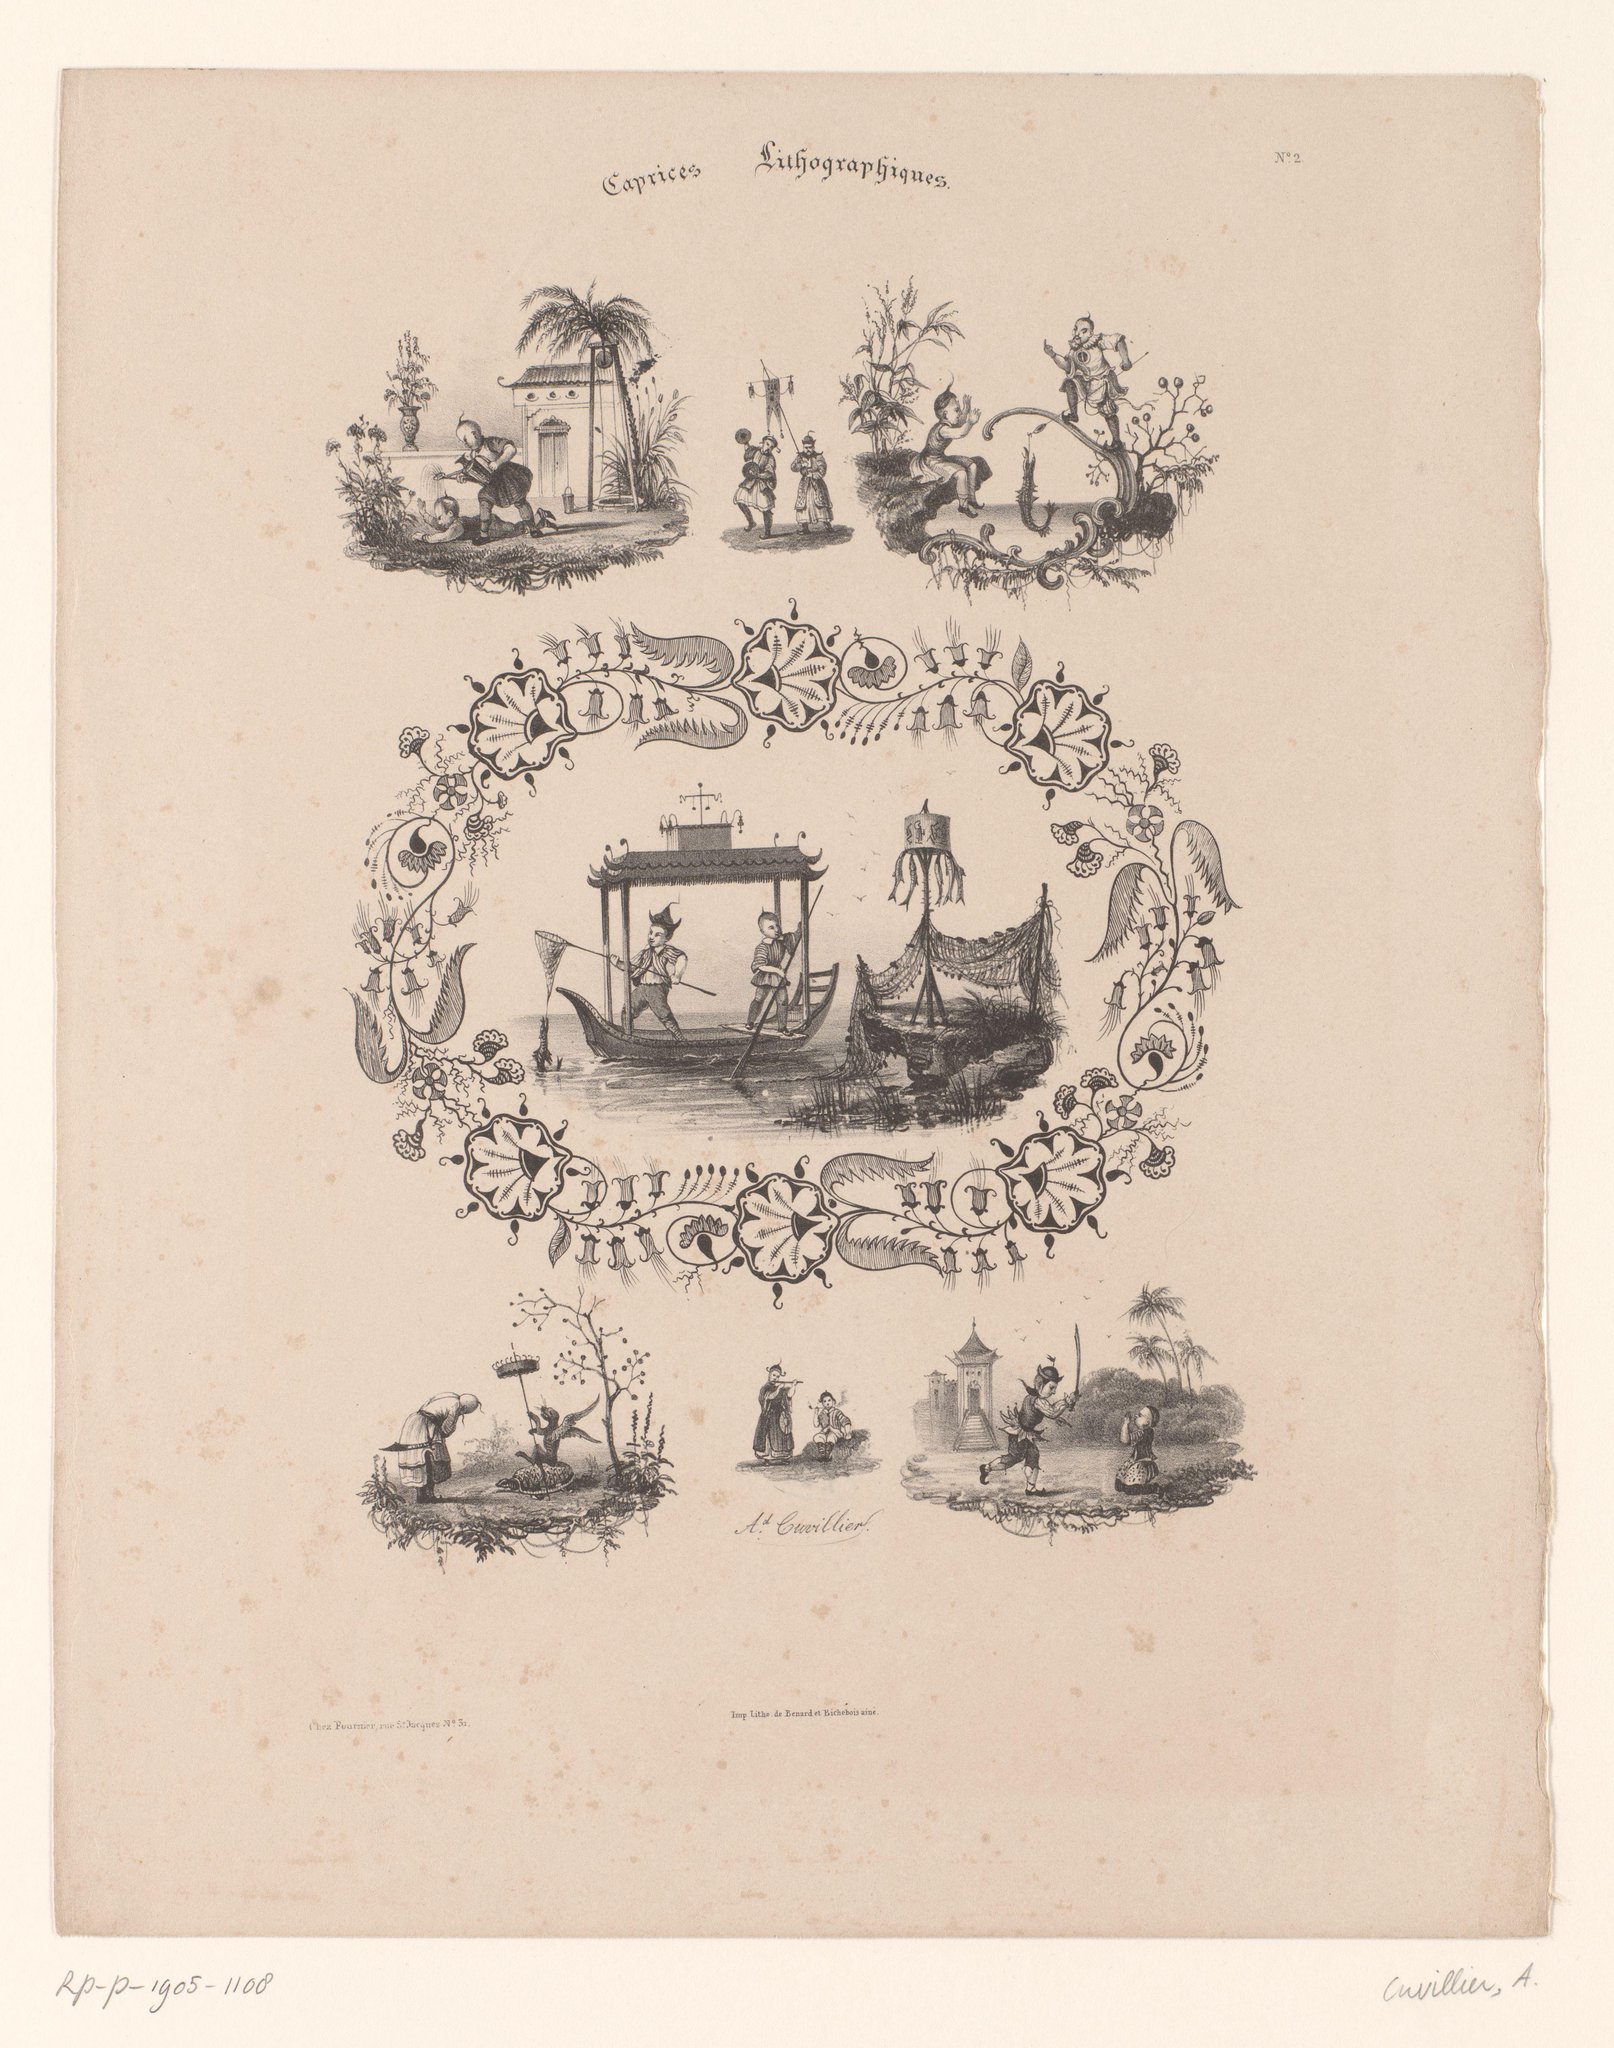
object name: print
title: Zeven voorstellingen met karikaturen van Chinese figuren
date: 1835-1849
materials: paper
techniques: lithograph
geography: paris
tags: chinese, caricatures (human types)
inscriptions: collector's mark: Lugt 2228a